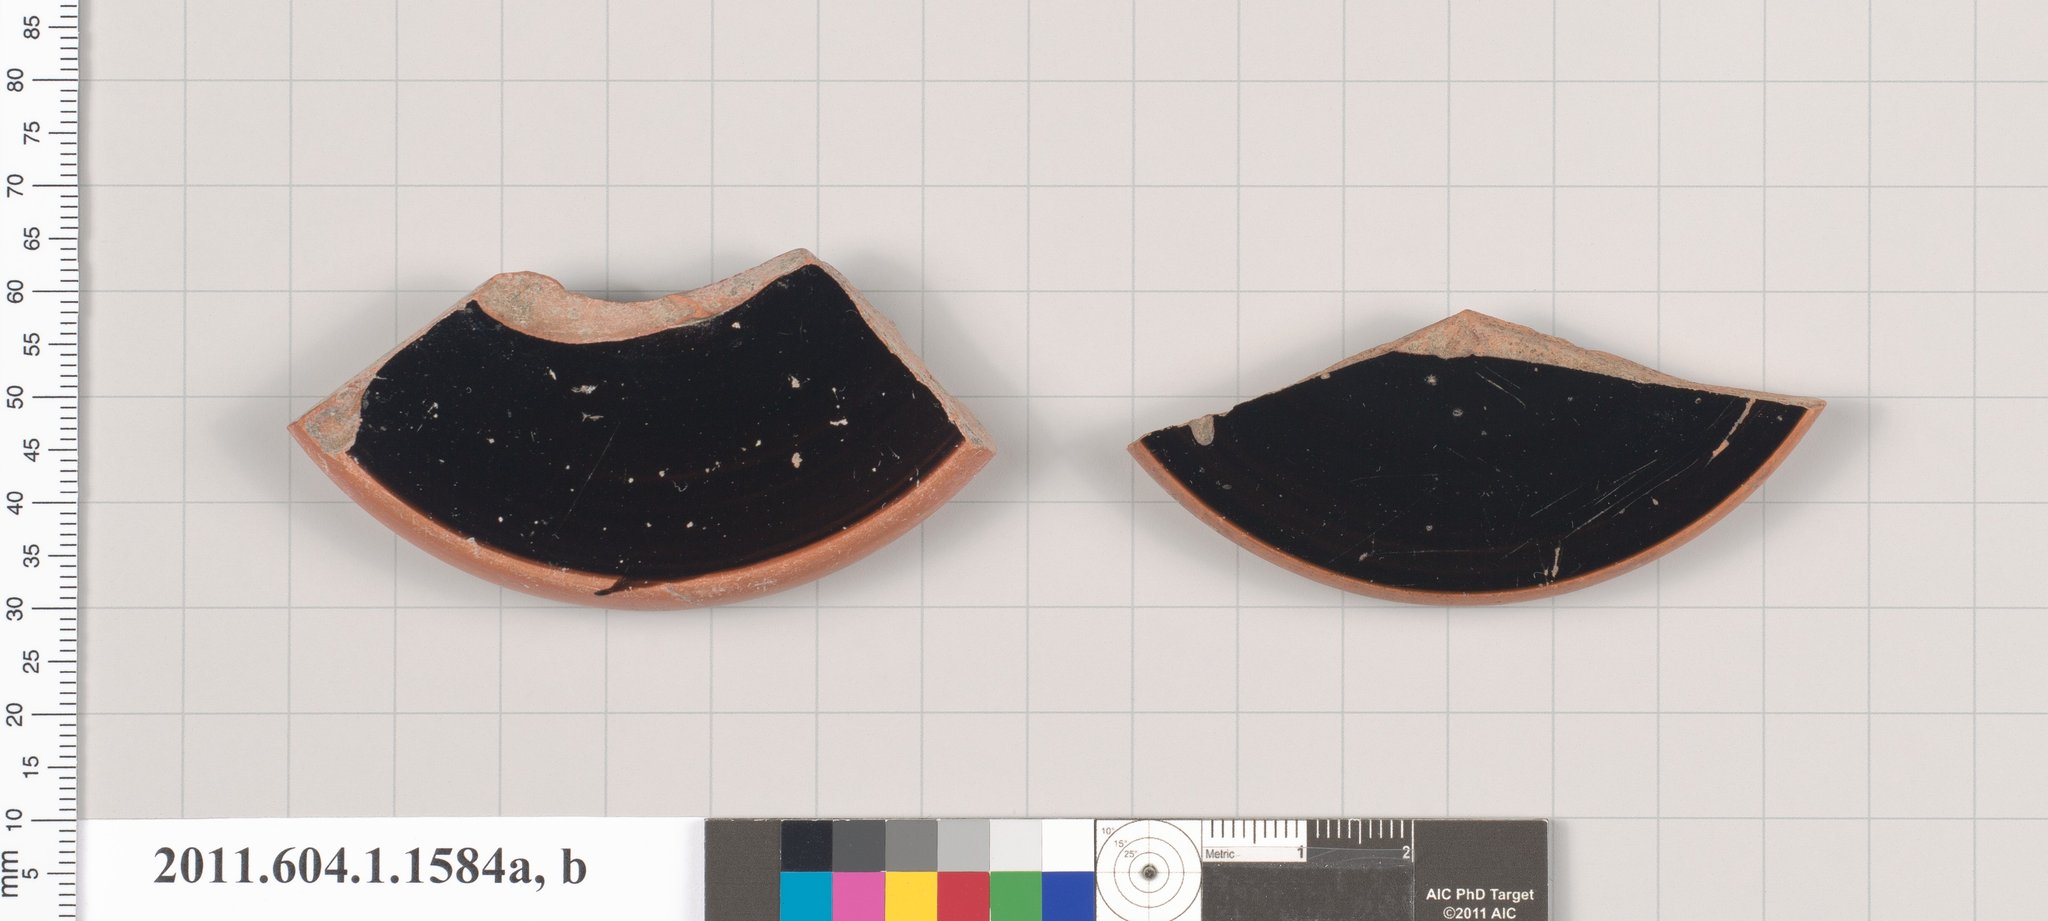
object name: kylix fragment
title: Terracotta fragments of kylikes (drinking cups)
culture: greek, attic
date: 500-401 BCE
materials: terracotta